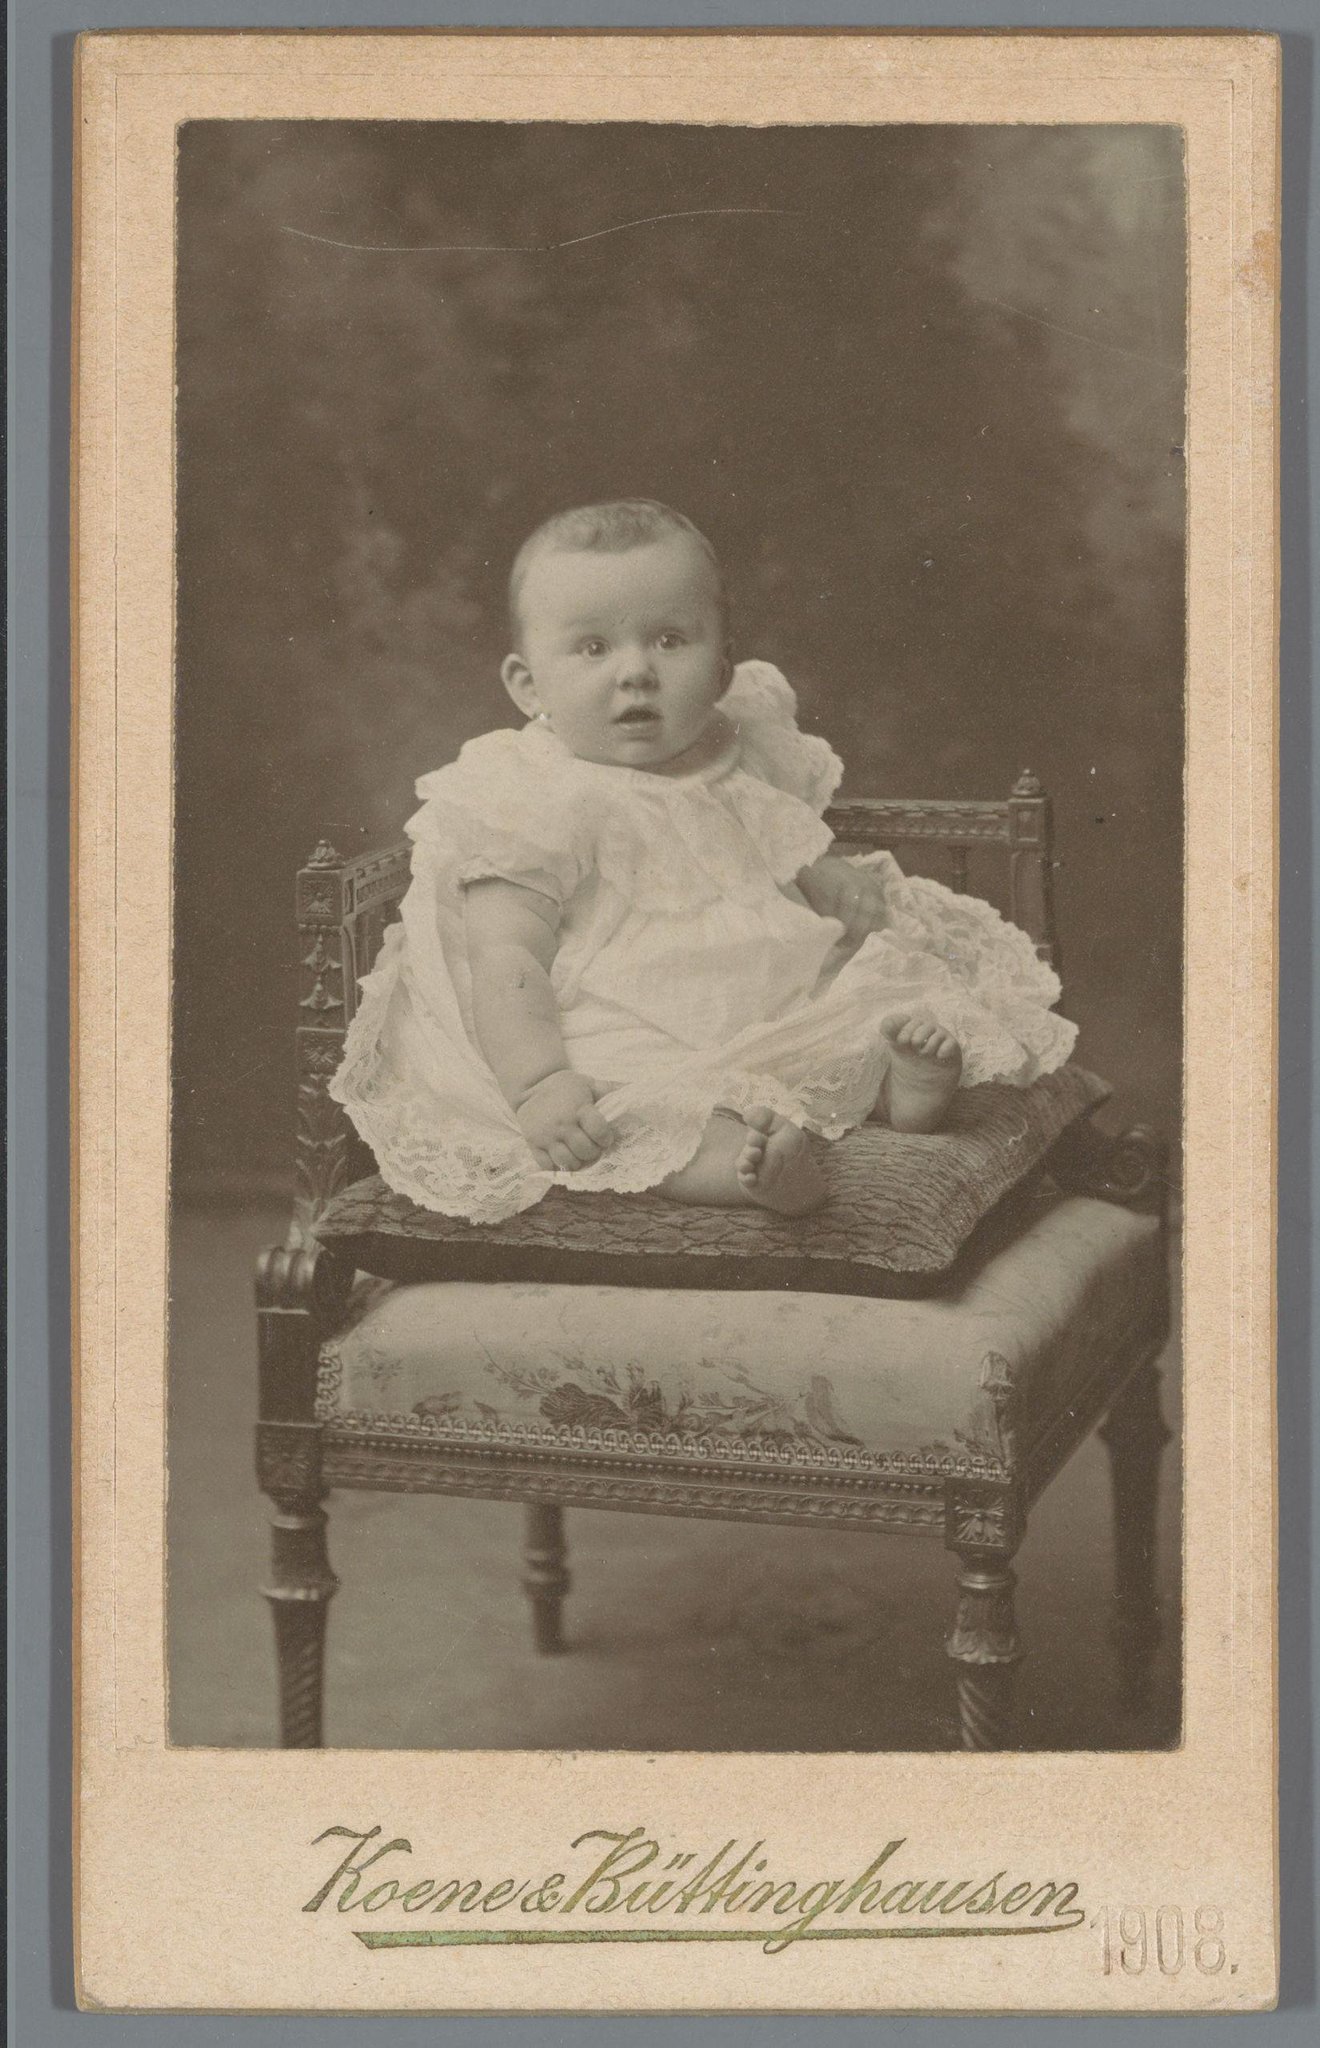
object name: carte de visite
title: Portret van een onbekende baby op een kussen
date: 1908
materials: paper, cardboard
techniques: gelatin silver print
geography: amsterdam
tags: anonymous historical person portrayed, infant, baby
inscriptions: address: ‘Amsterdam/ Heerengracht 150./ Batavia.’, inscription: ‘TELEPHOONNUMMER 1402.’